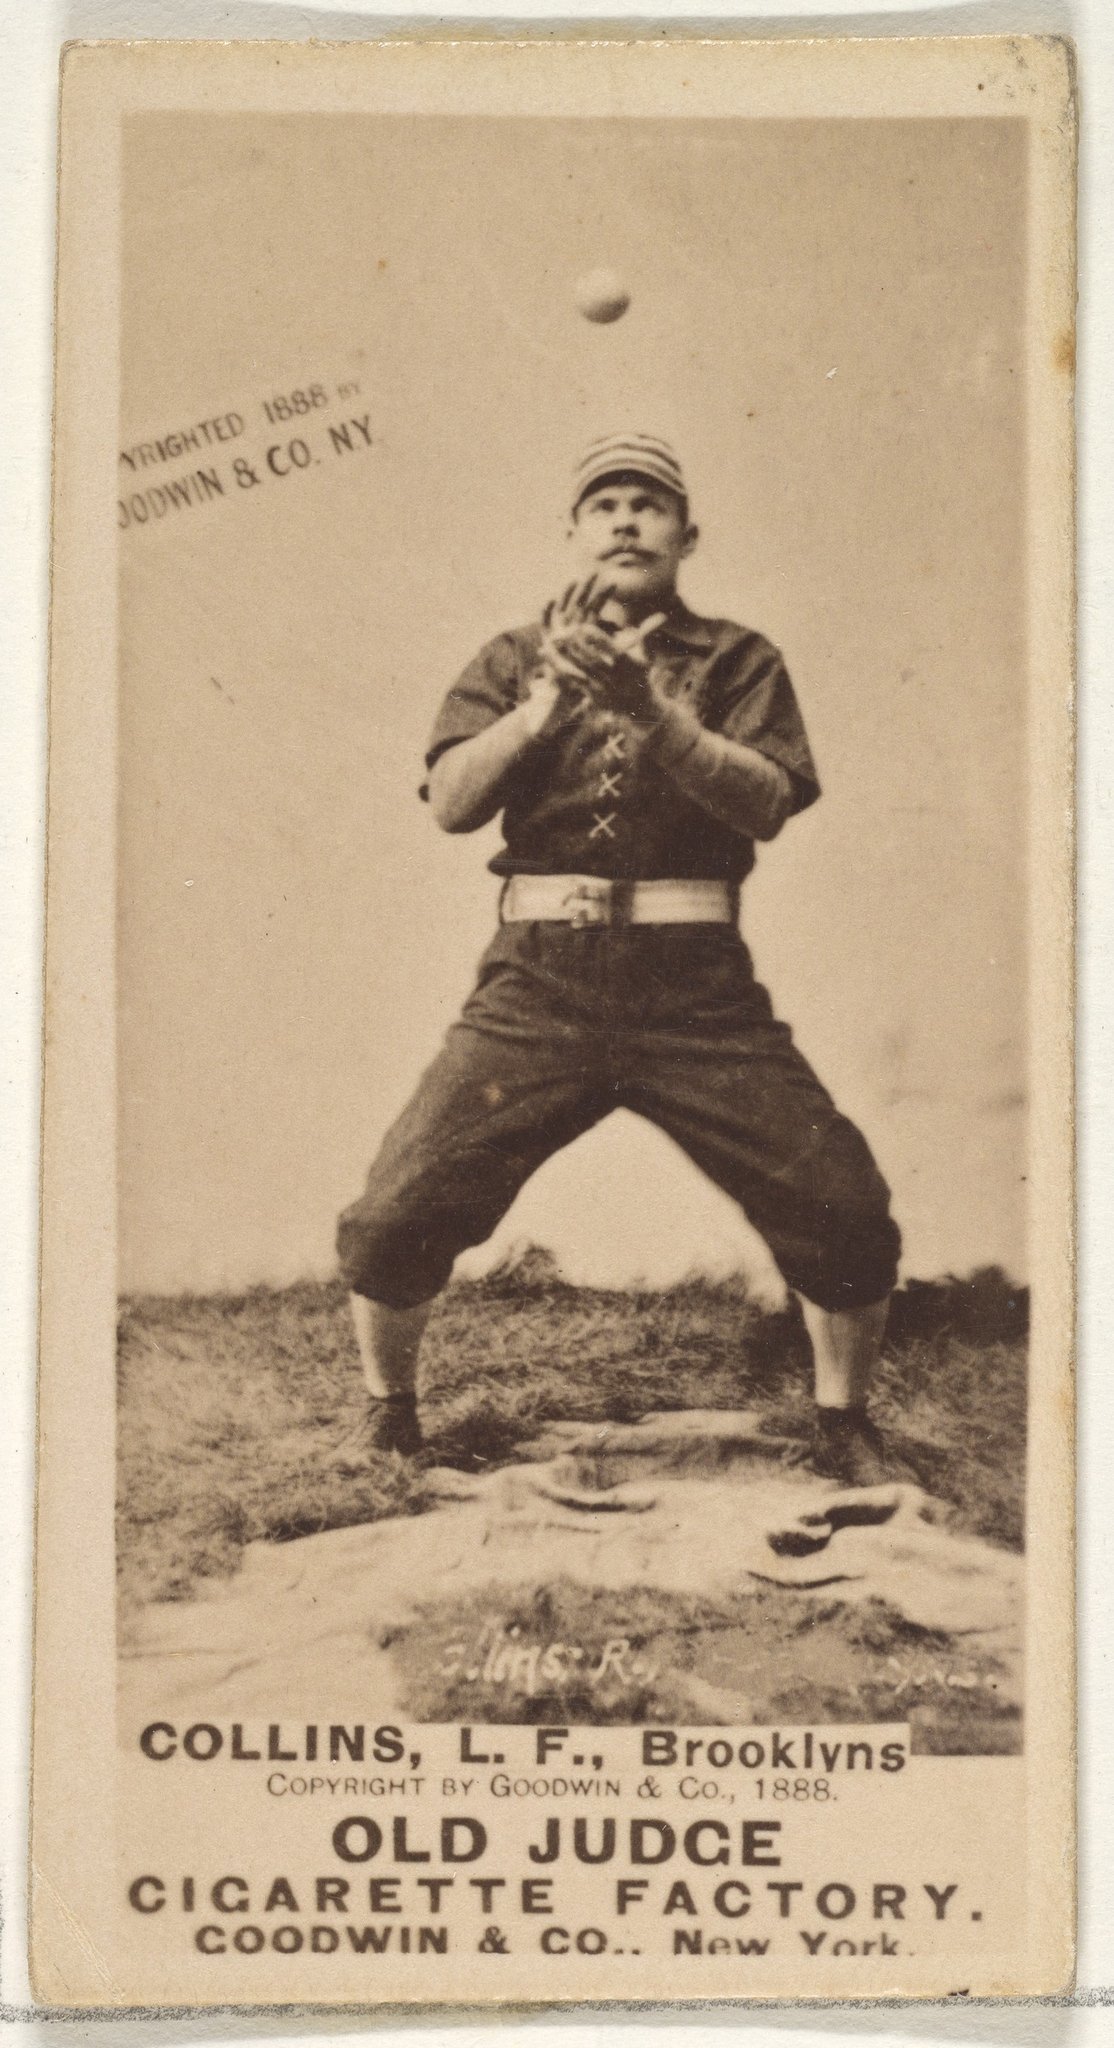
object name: baseball card, photograph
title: Collins, Left Field, Brooklyn Bridegrooms, from the Old Judge series (N172) for Old Judge Cigarettes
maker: goodwin & company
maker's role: publisher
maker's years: 1850-1950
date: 1888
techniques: albumen silver print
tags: men,portraits,baseball,athletes